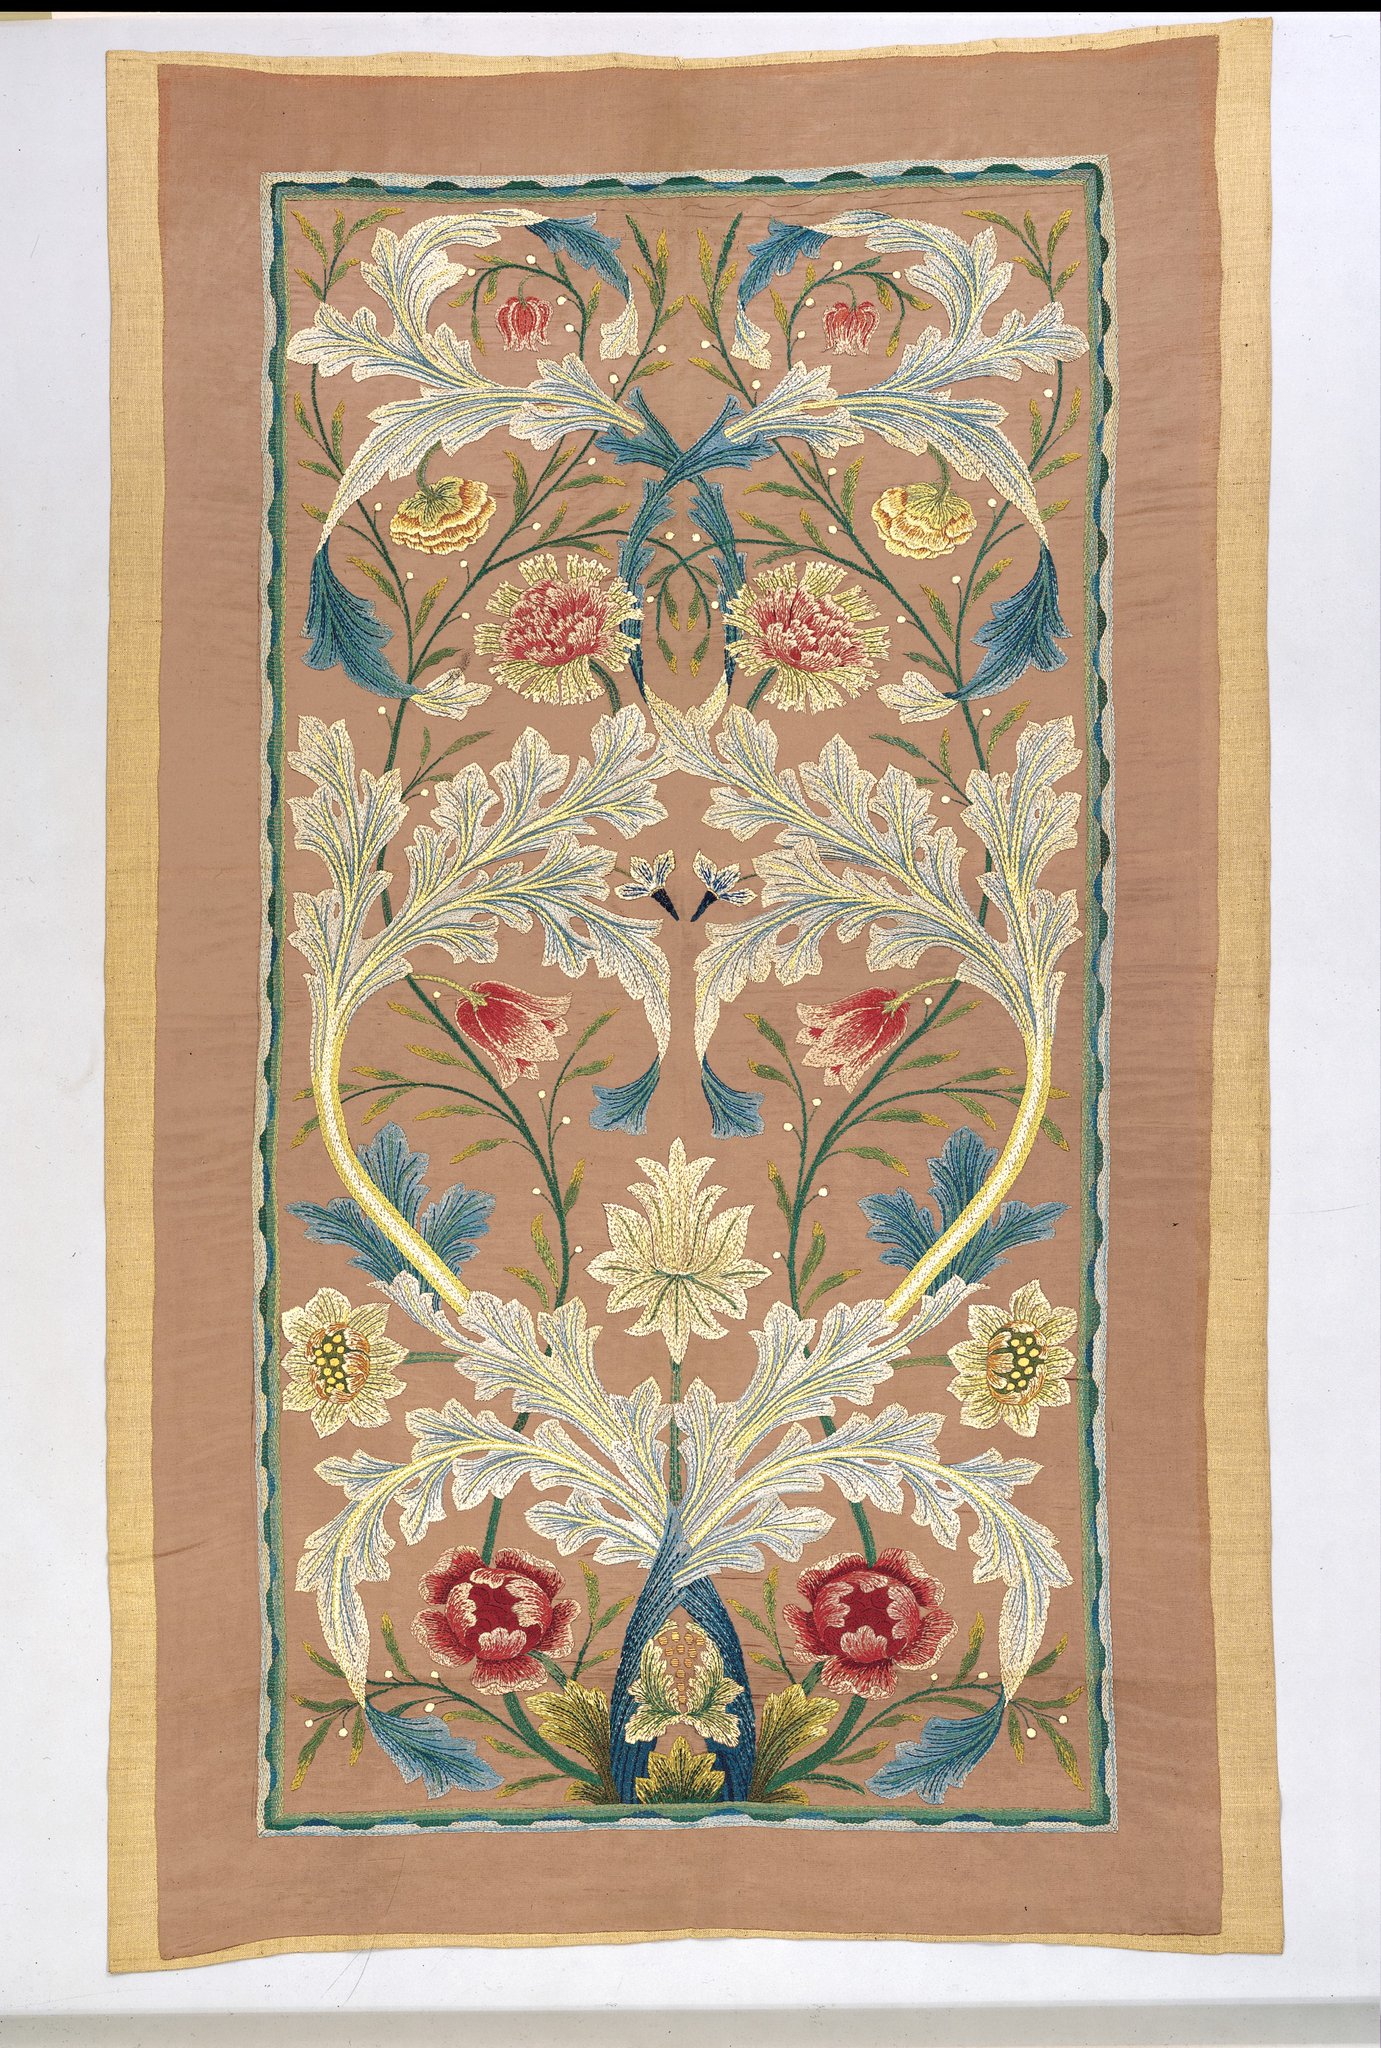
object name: panel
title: Panel of floral embroidery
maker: william morris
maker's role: designer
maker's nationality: british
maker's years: 1834-1896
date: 1875-1880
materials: linen, silk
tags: flowers